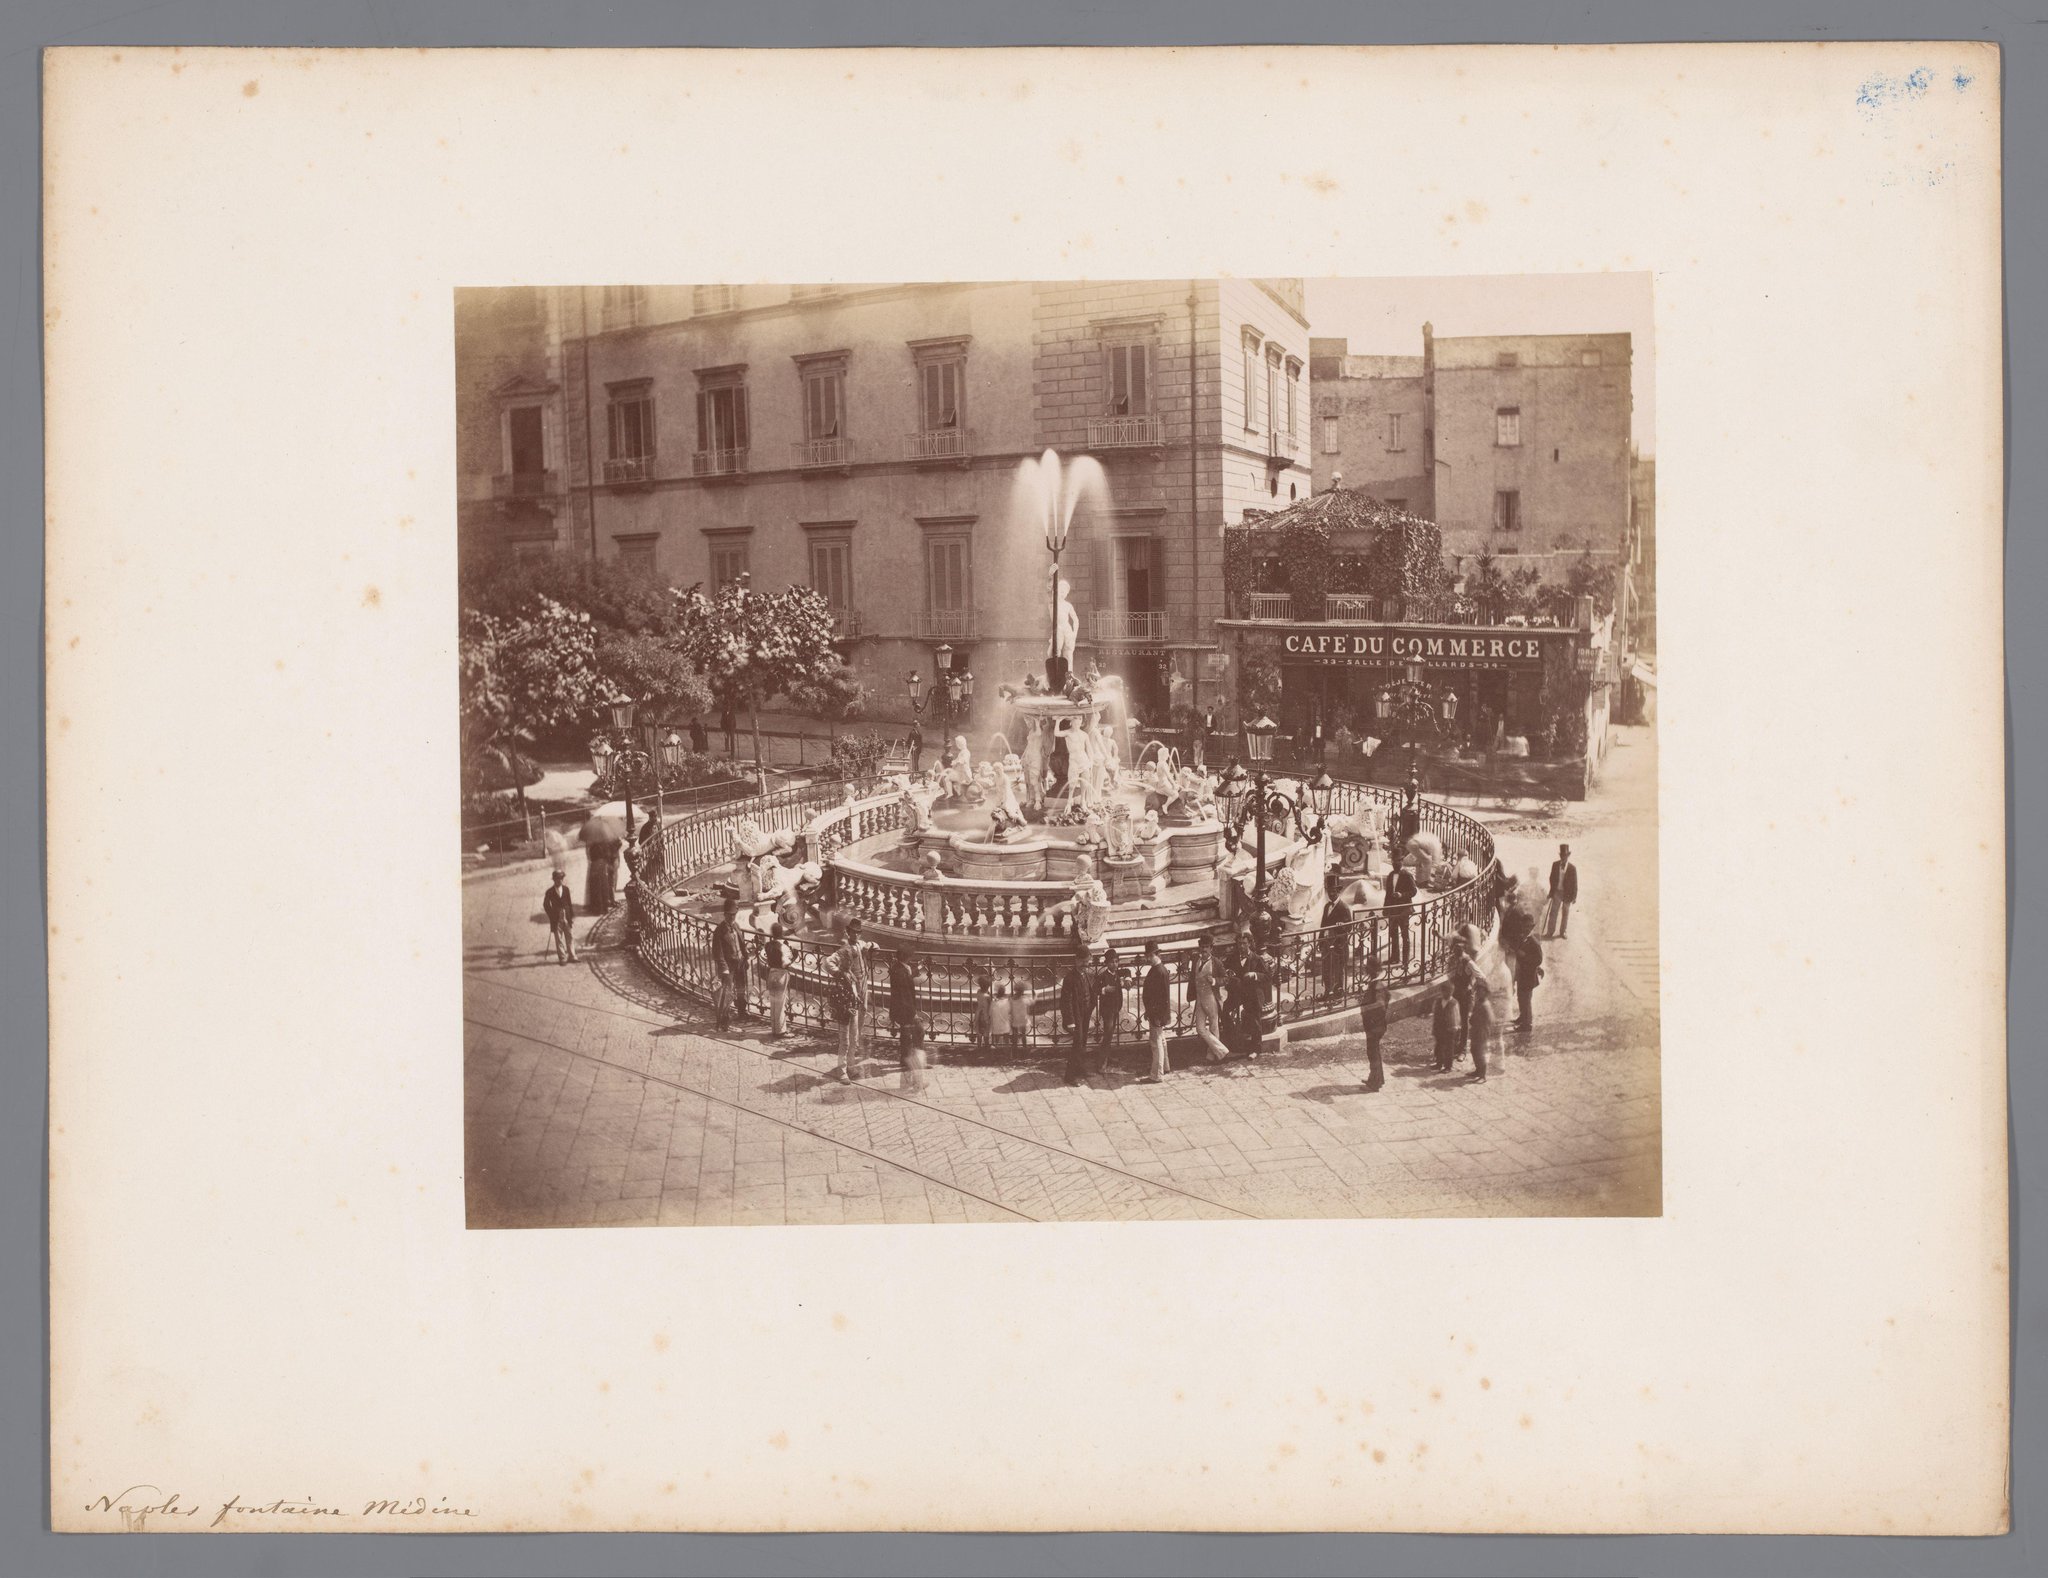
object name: photograph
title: Naples fontaine Médine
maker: Anonymous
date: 1851-1900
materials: cardboard, paper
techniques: albumen print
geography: naples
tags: ornamental fountain, naples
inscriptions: number: ‘12’, number: ‘21.’